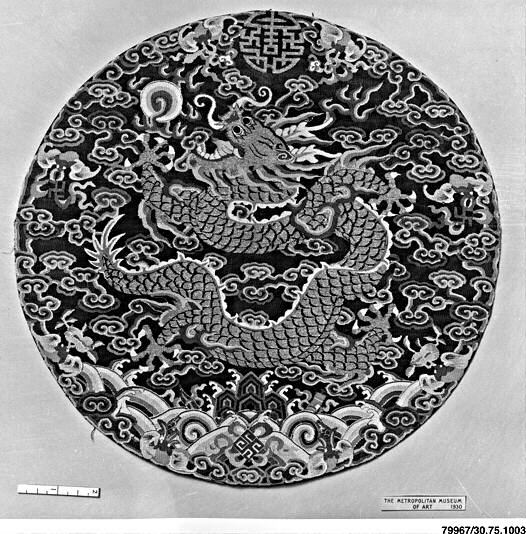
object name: insignia medallion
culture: chinese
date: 1801-1900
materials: silk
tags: dragons